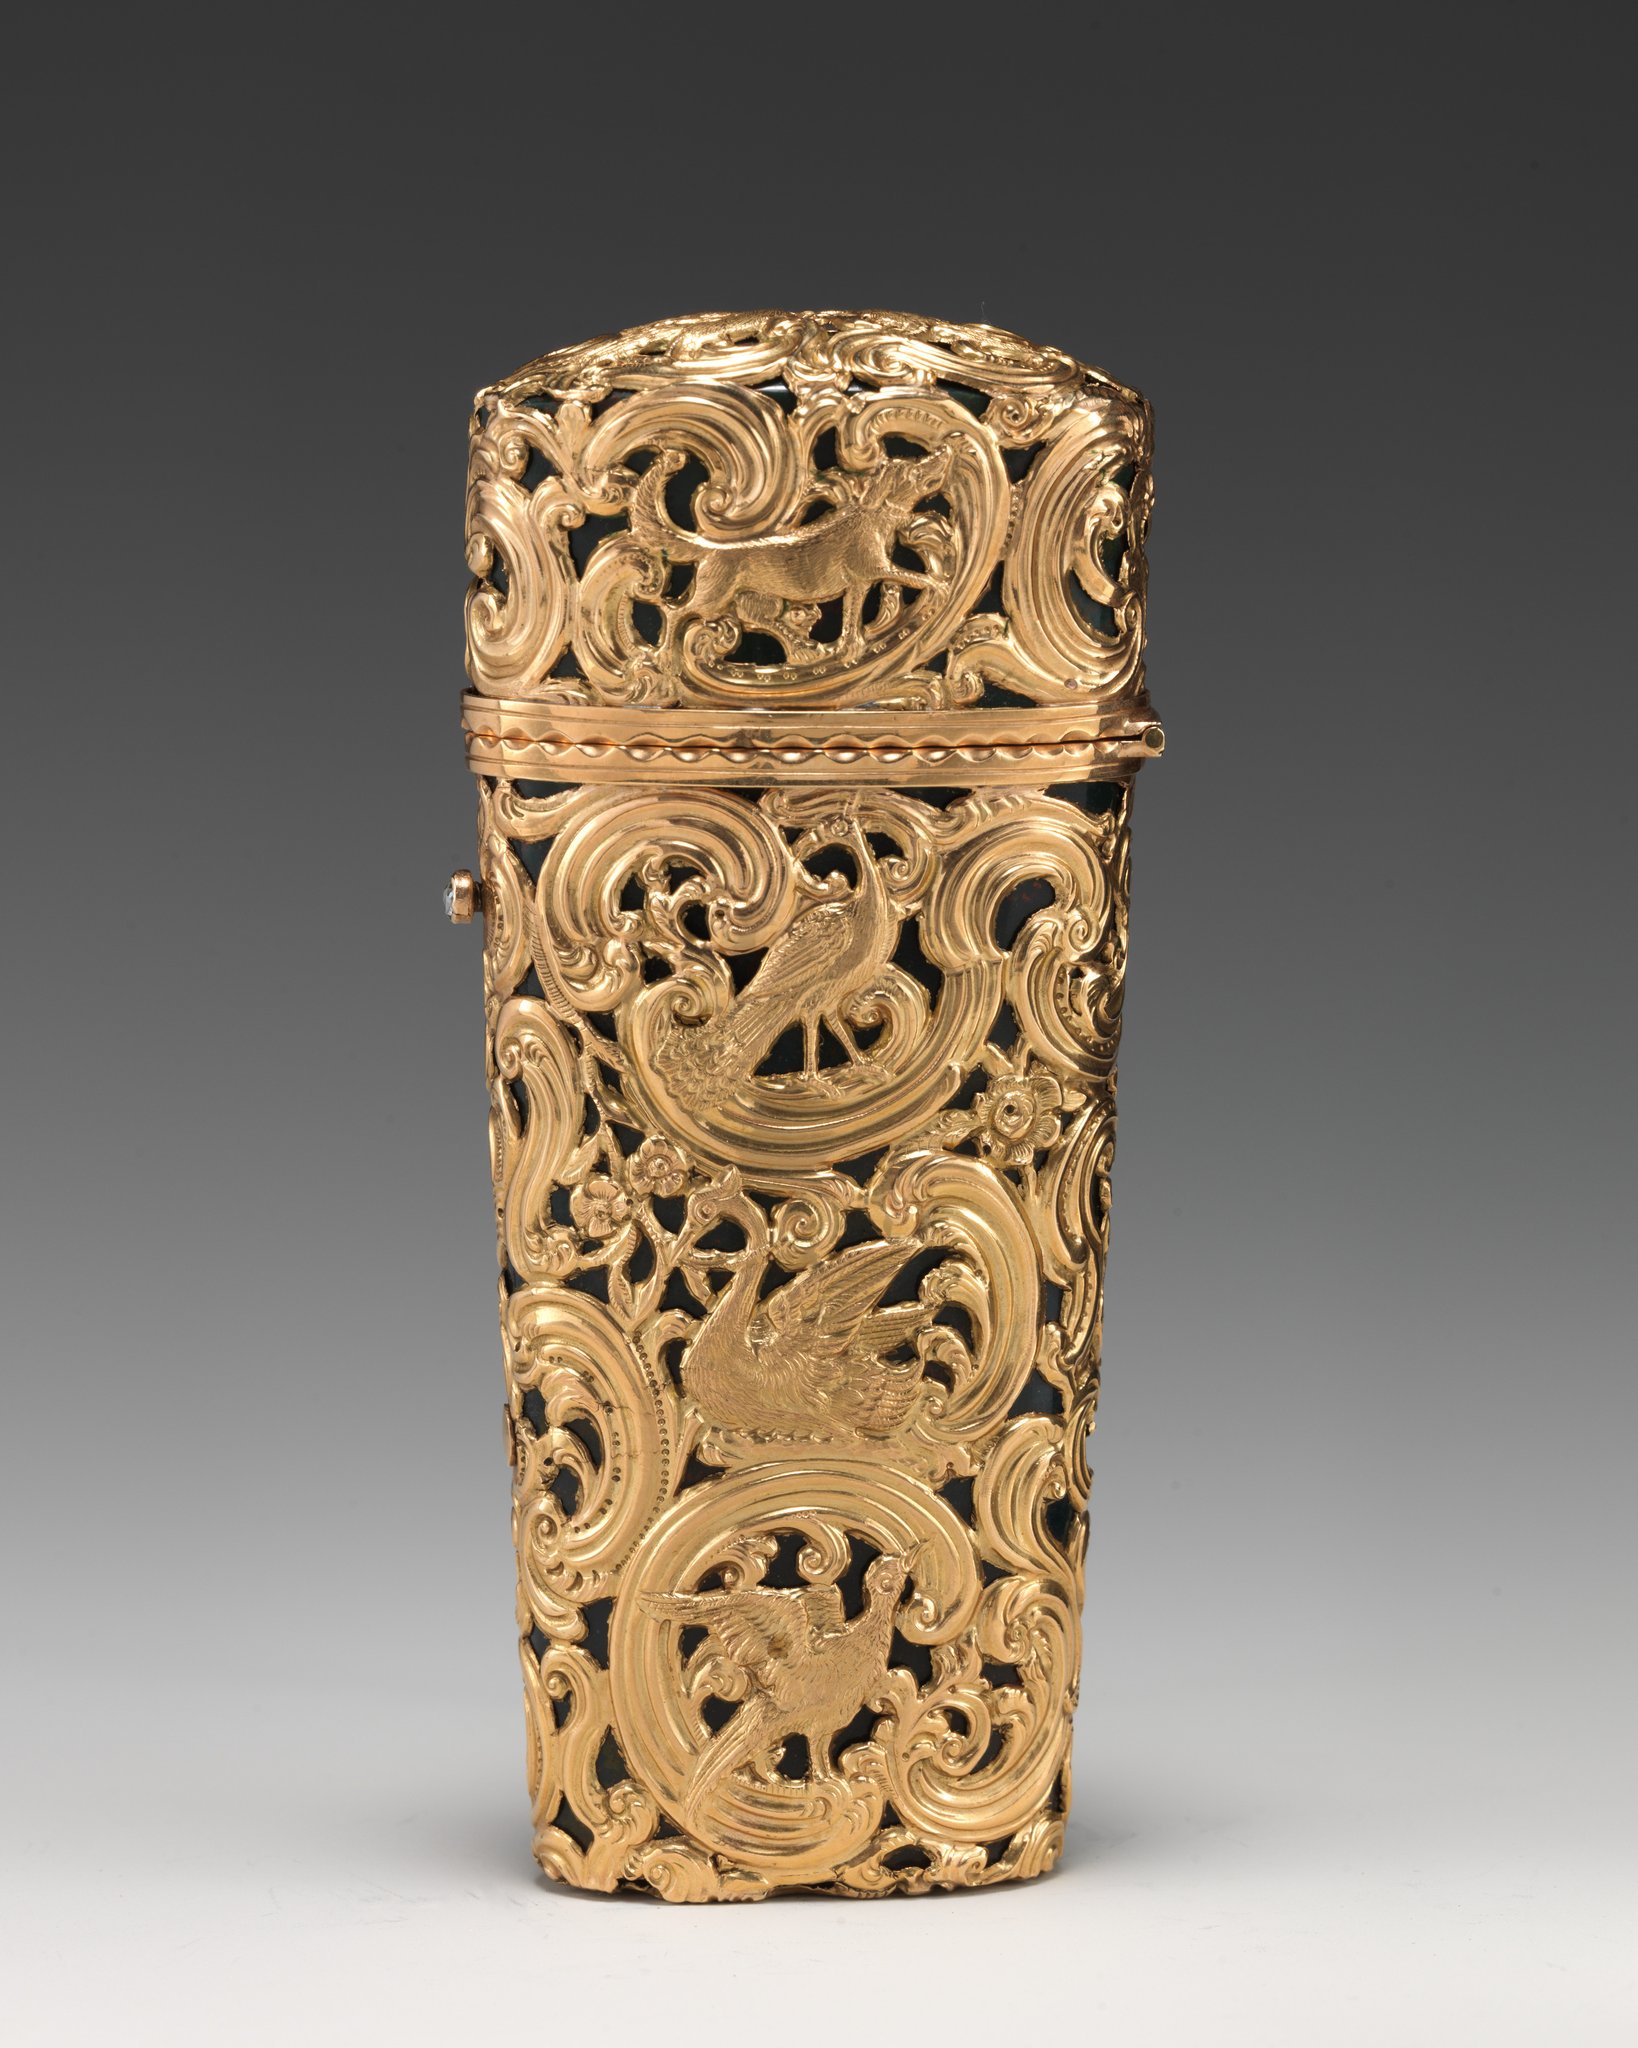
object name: nécessaire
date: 1810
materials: stone, gold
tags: animals,birds